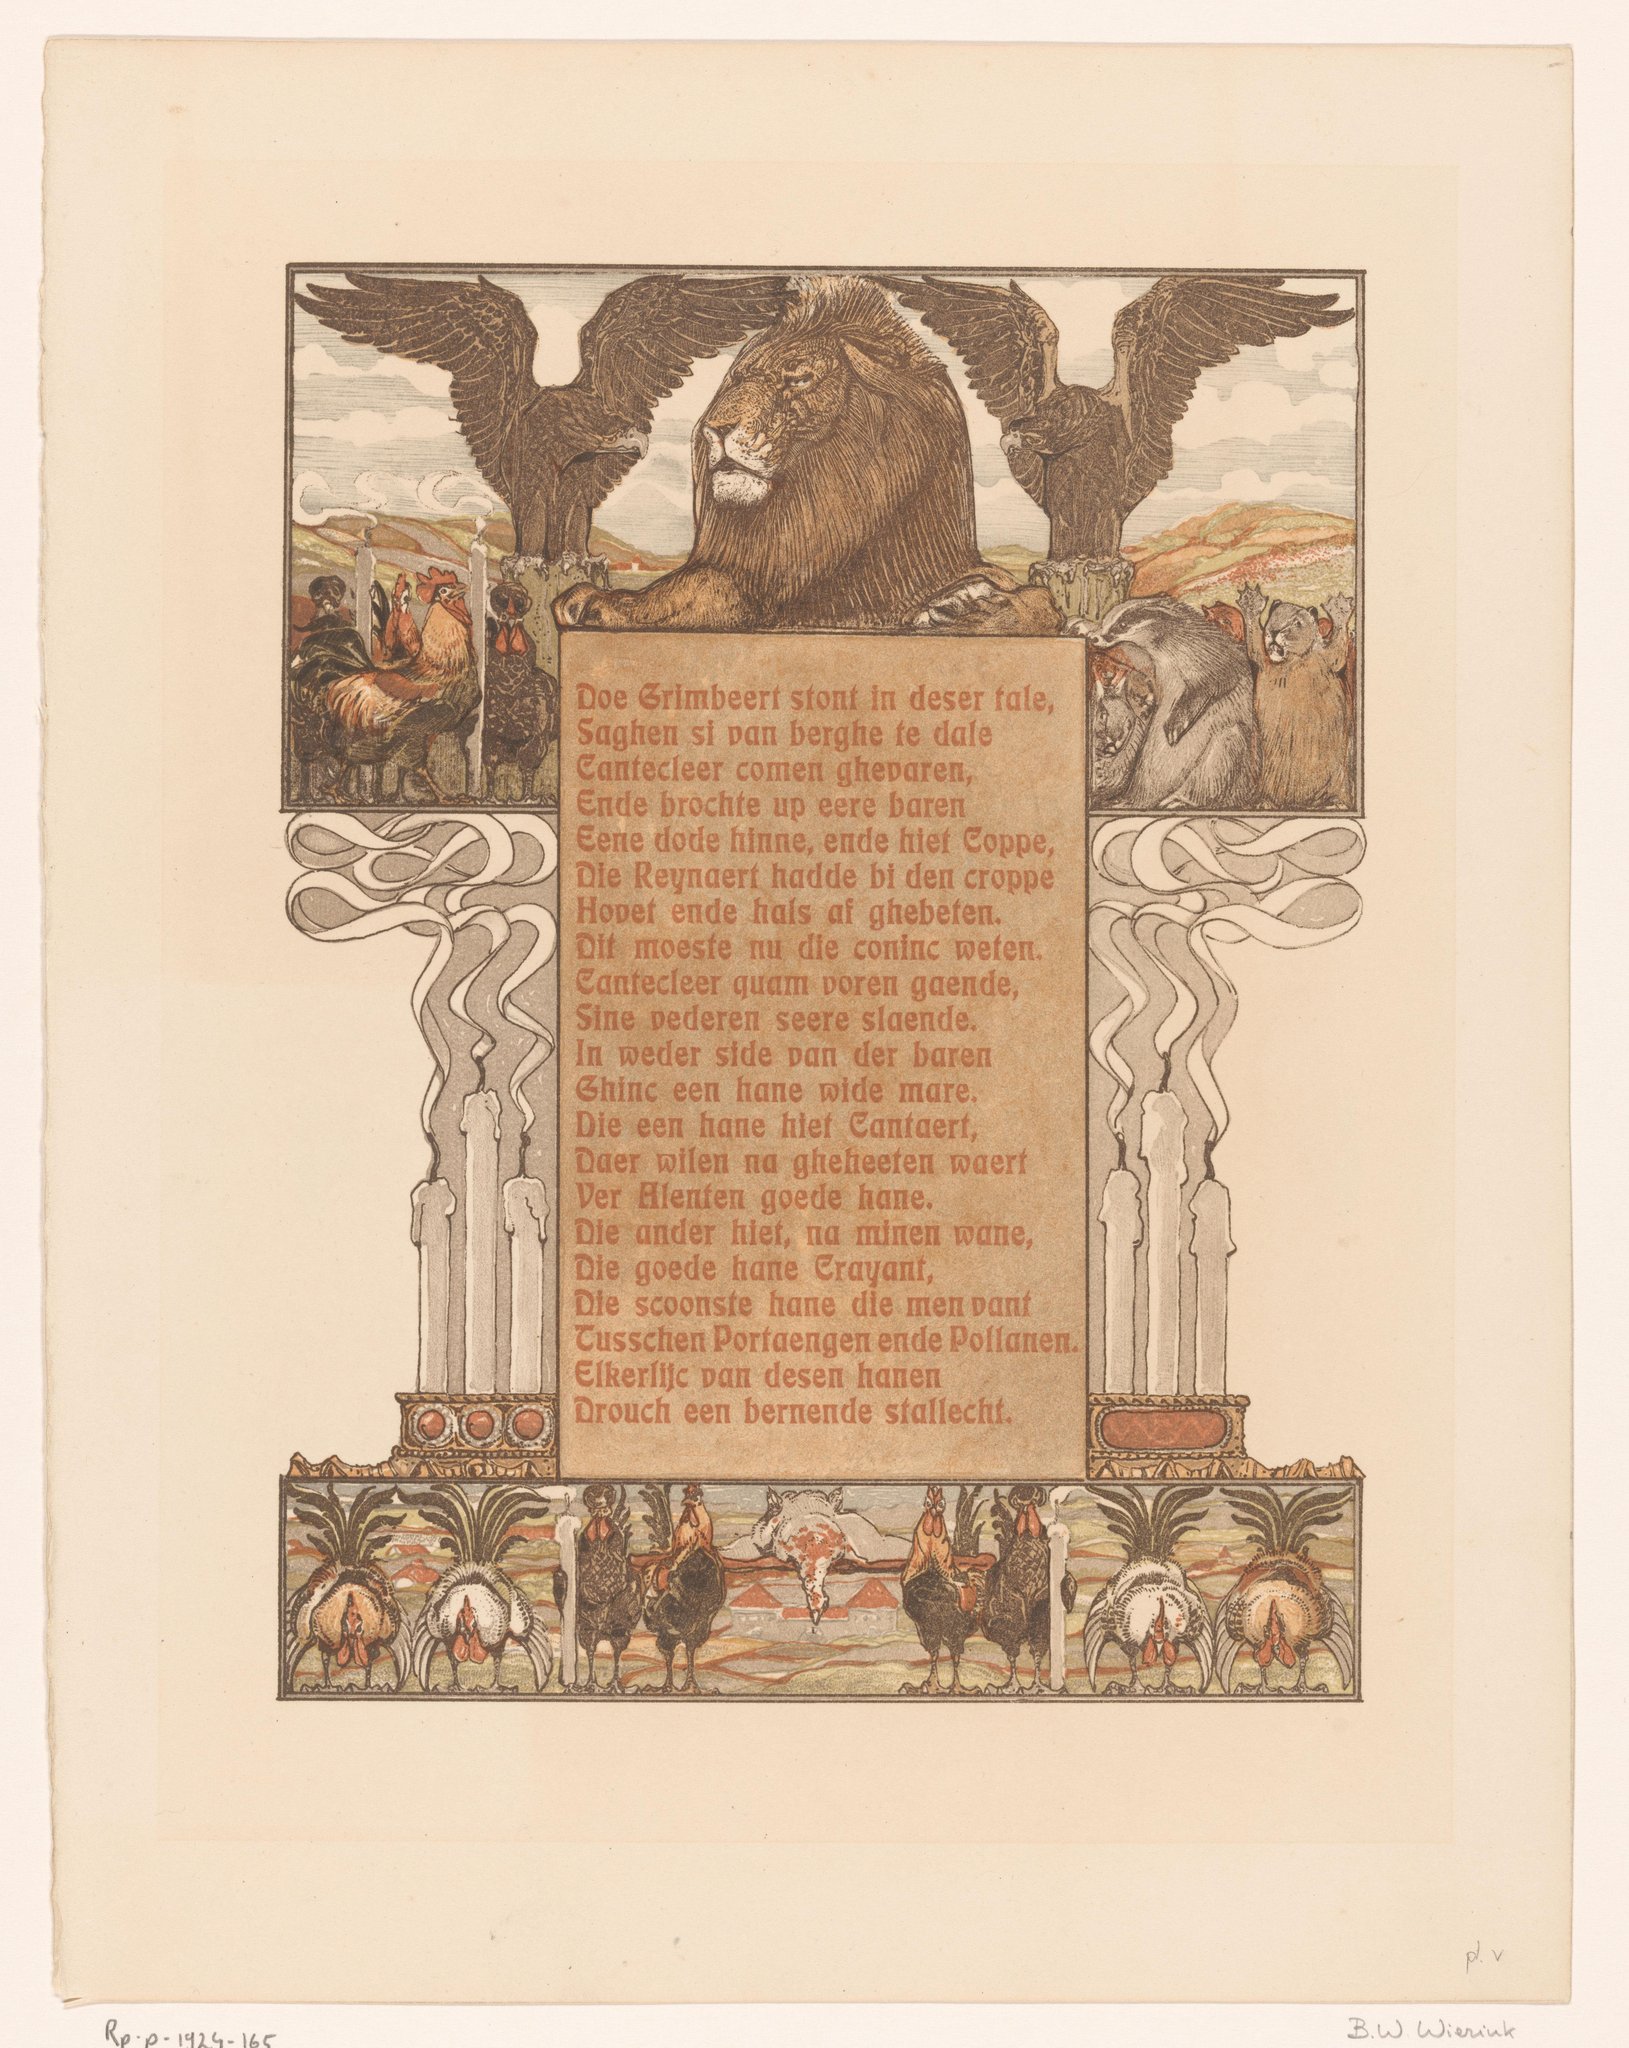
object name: print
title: Gedoofde kaarsen en leeuw (Nobel) geflankeerd door adelaars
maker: bernard willem wierink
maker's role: draughtsman, print maker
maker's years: 1856-1939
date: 1910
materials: paper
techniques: lithograph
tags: fable of reynard the fox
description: Prent gebruikt in: Streuvels, Stijn (Frank Lateur). Reinaert de Vos naar verschillende uitgaven van het middeleeuwsche epos. Amsterdam: L.J. Veen, 1910.